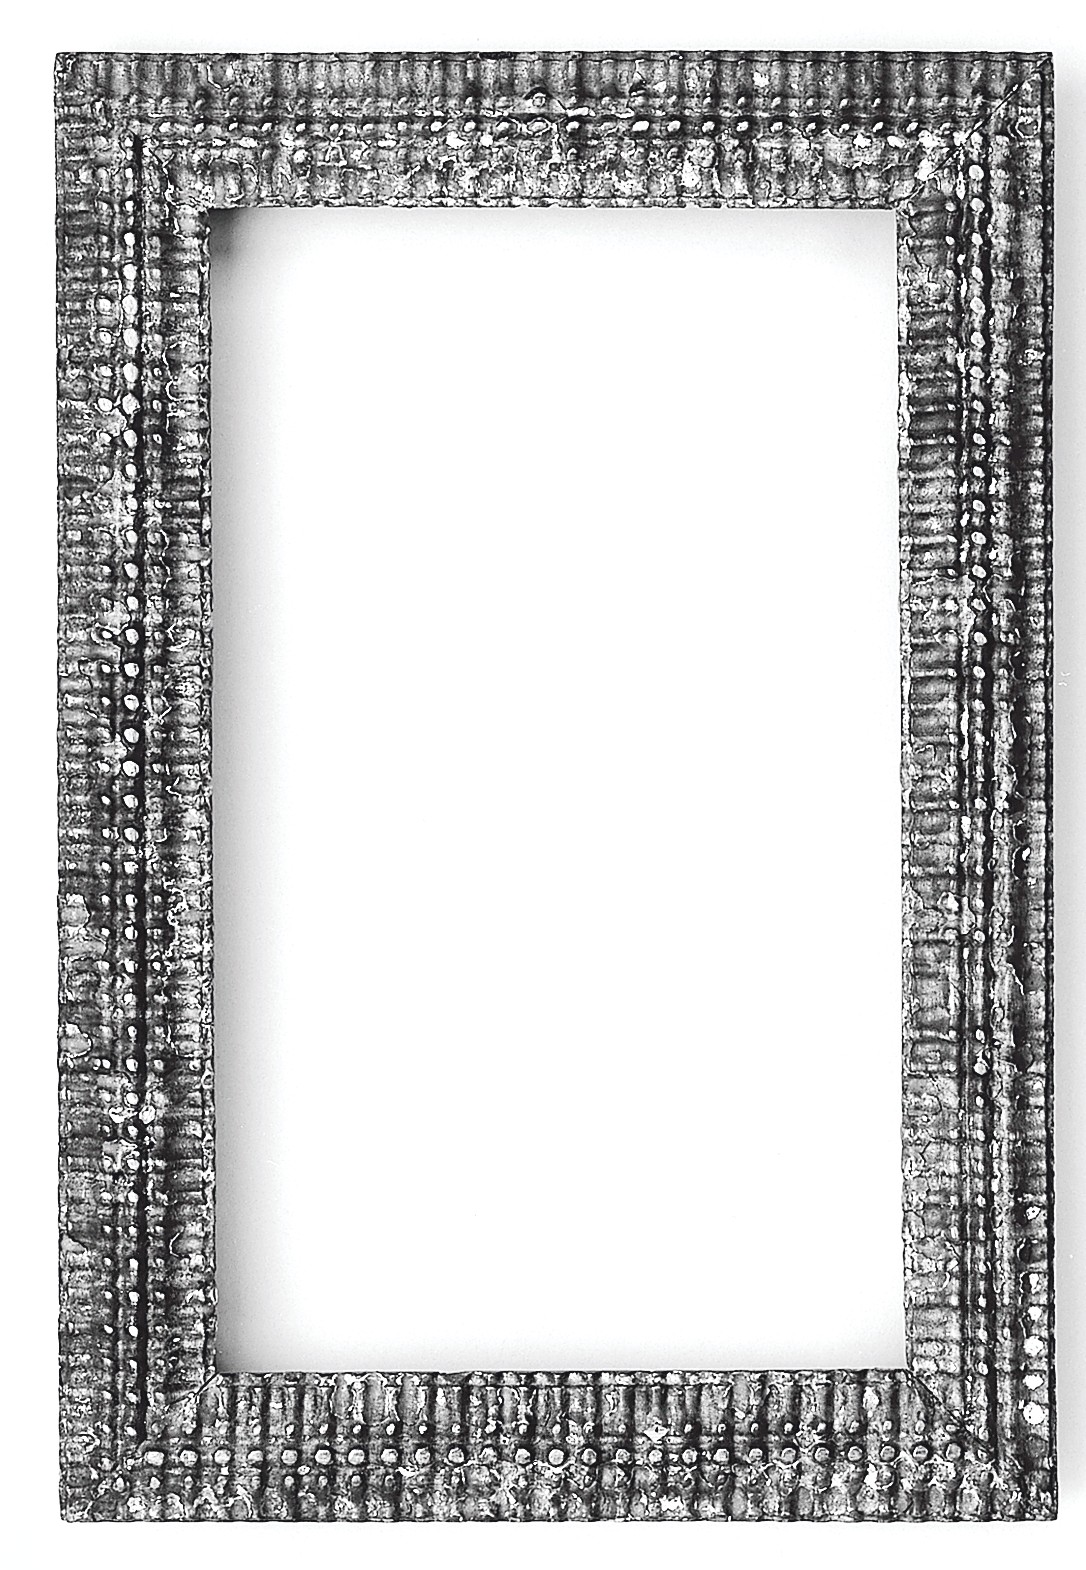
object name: frame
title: Ripple molding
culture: spanish or central american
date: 1610-1670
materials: wood